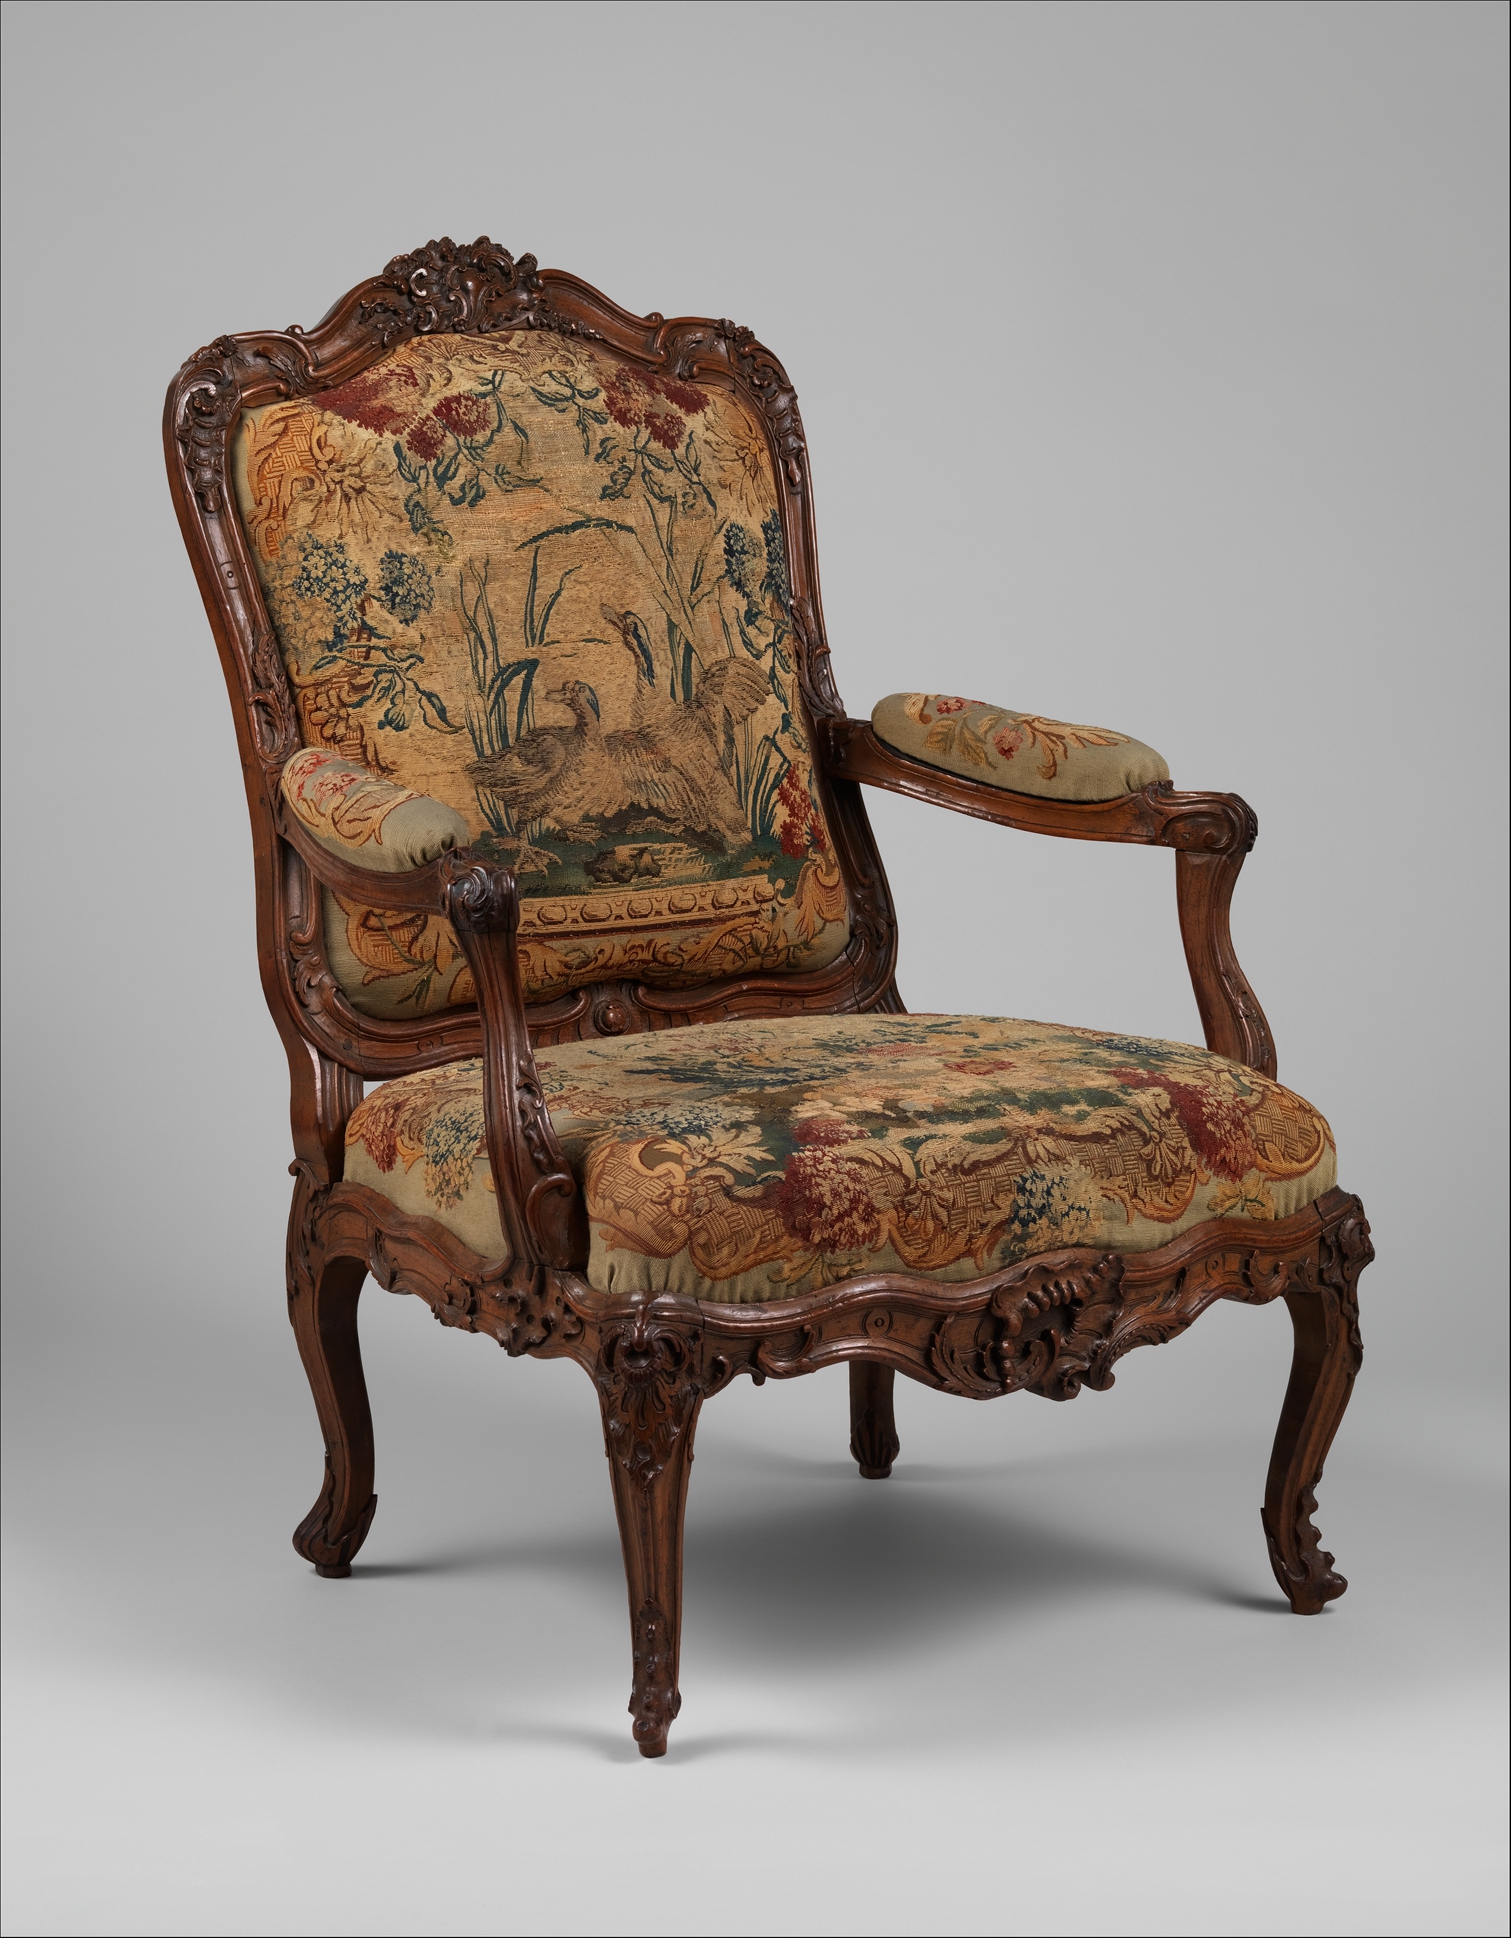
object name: armchair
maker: rené cresson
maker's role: maker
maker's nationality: french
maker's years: 1700-1800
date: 1735-1740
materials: wood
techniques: carving, tapestry